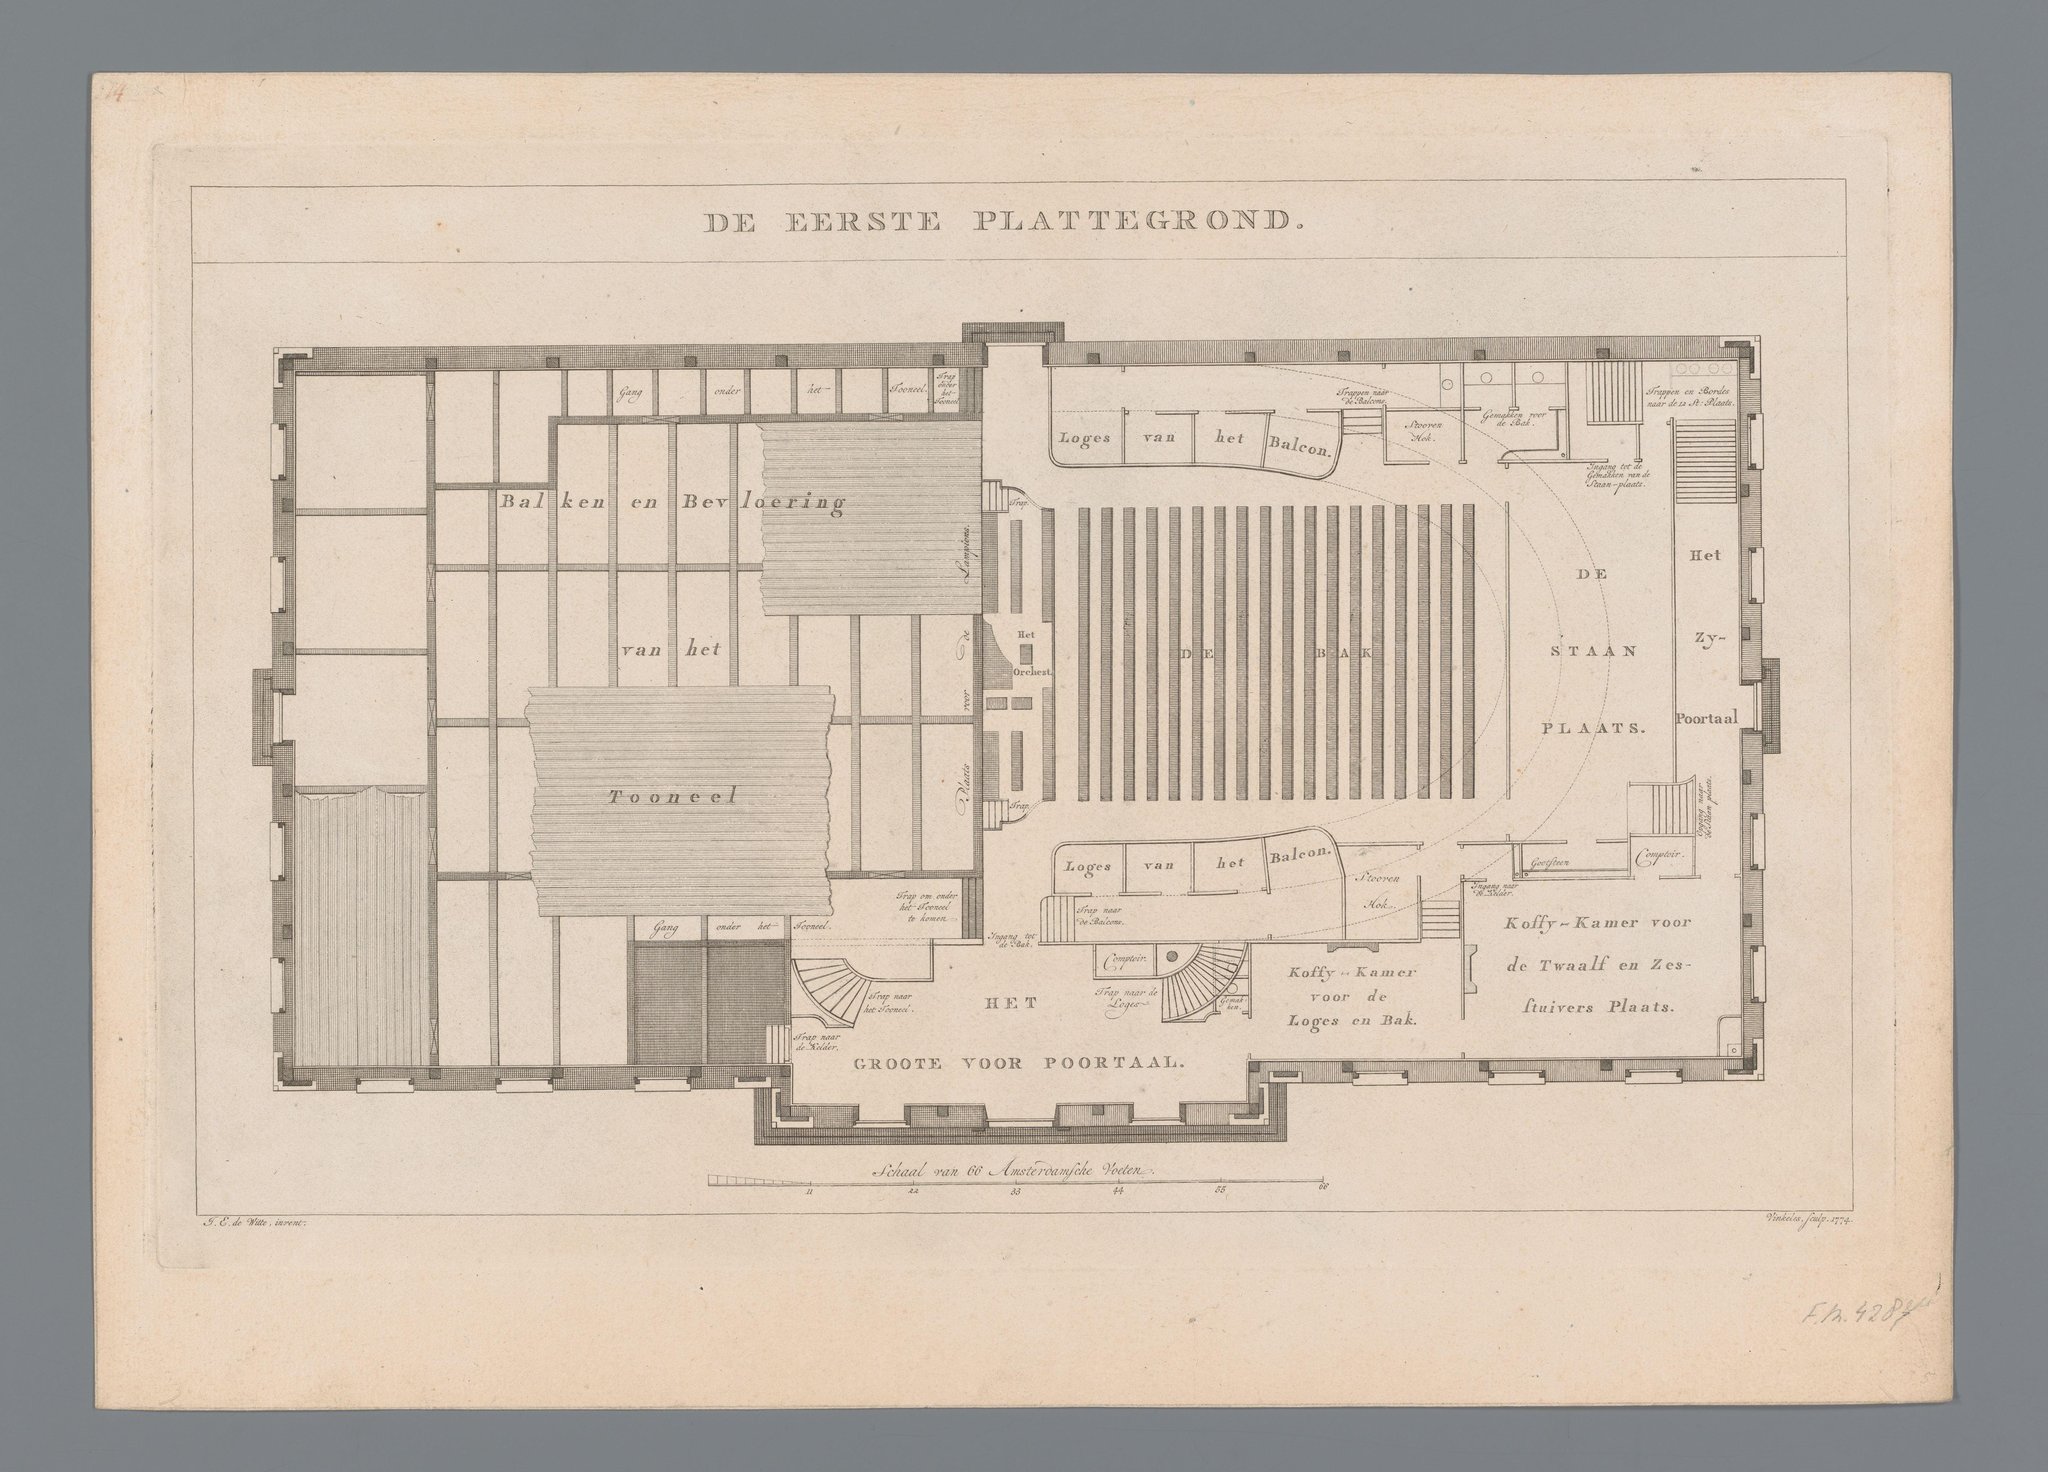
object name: area plan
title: De eerste plattegrond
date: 1774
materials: paper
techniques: etching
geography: amsterdam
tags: maps, atlases, theatre (building), amsterdam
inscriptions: date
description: Prent uit: Witte, Jacob Eduard de. Afbeeldingen van den schouwburg te Amsterdam. Amsterdam: Johannes Smit, 1774.